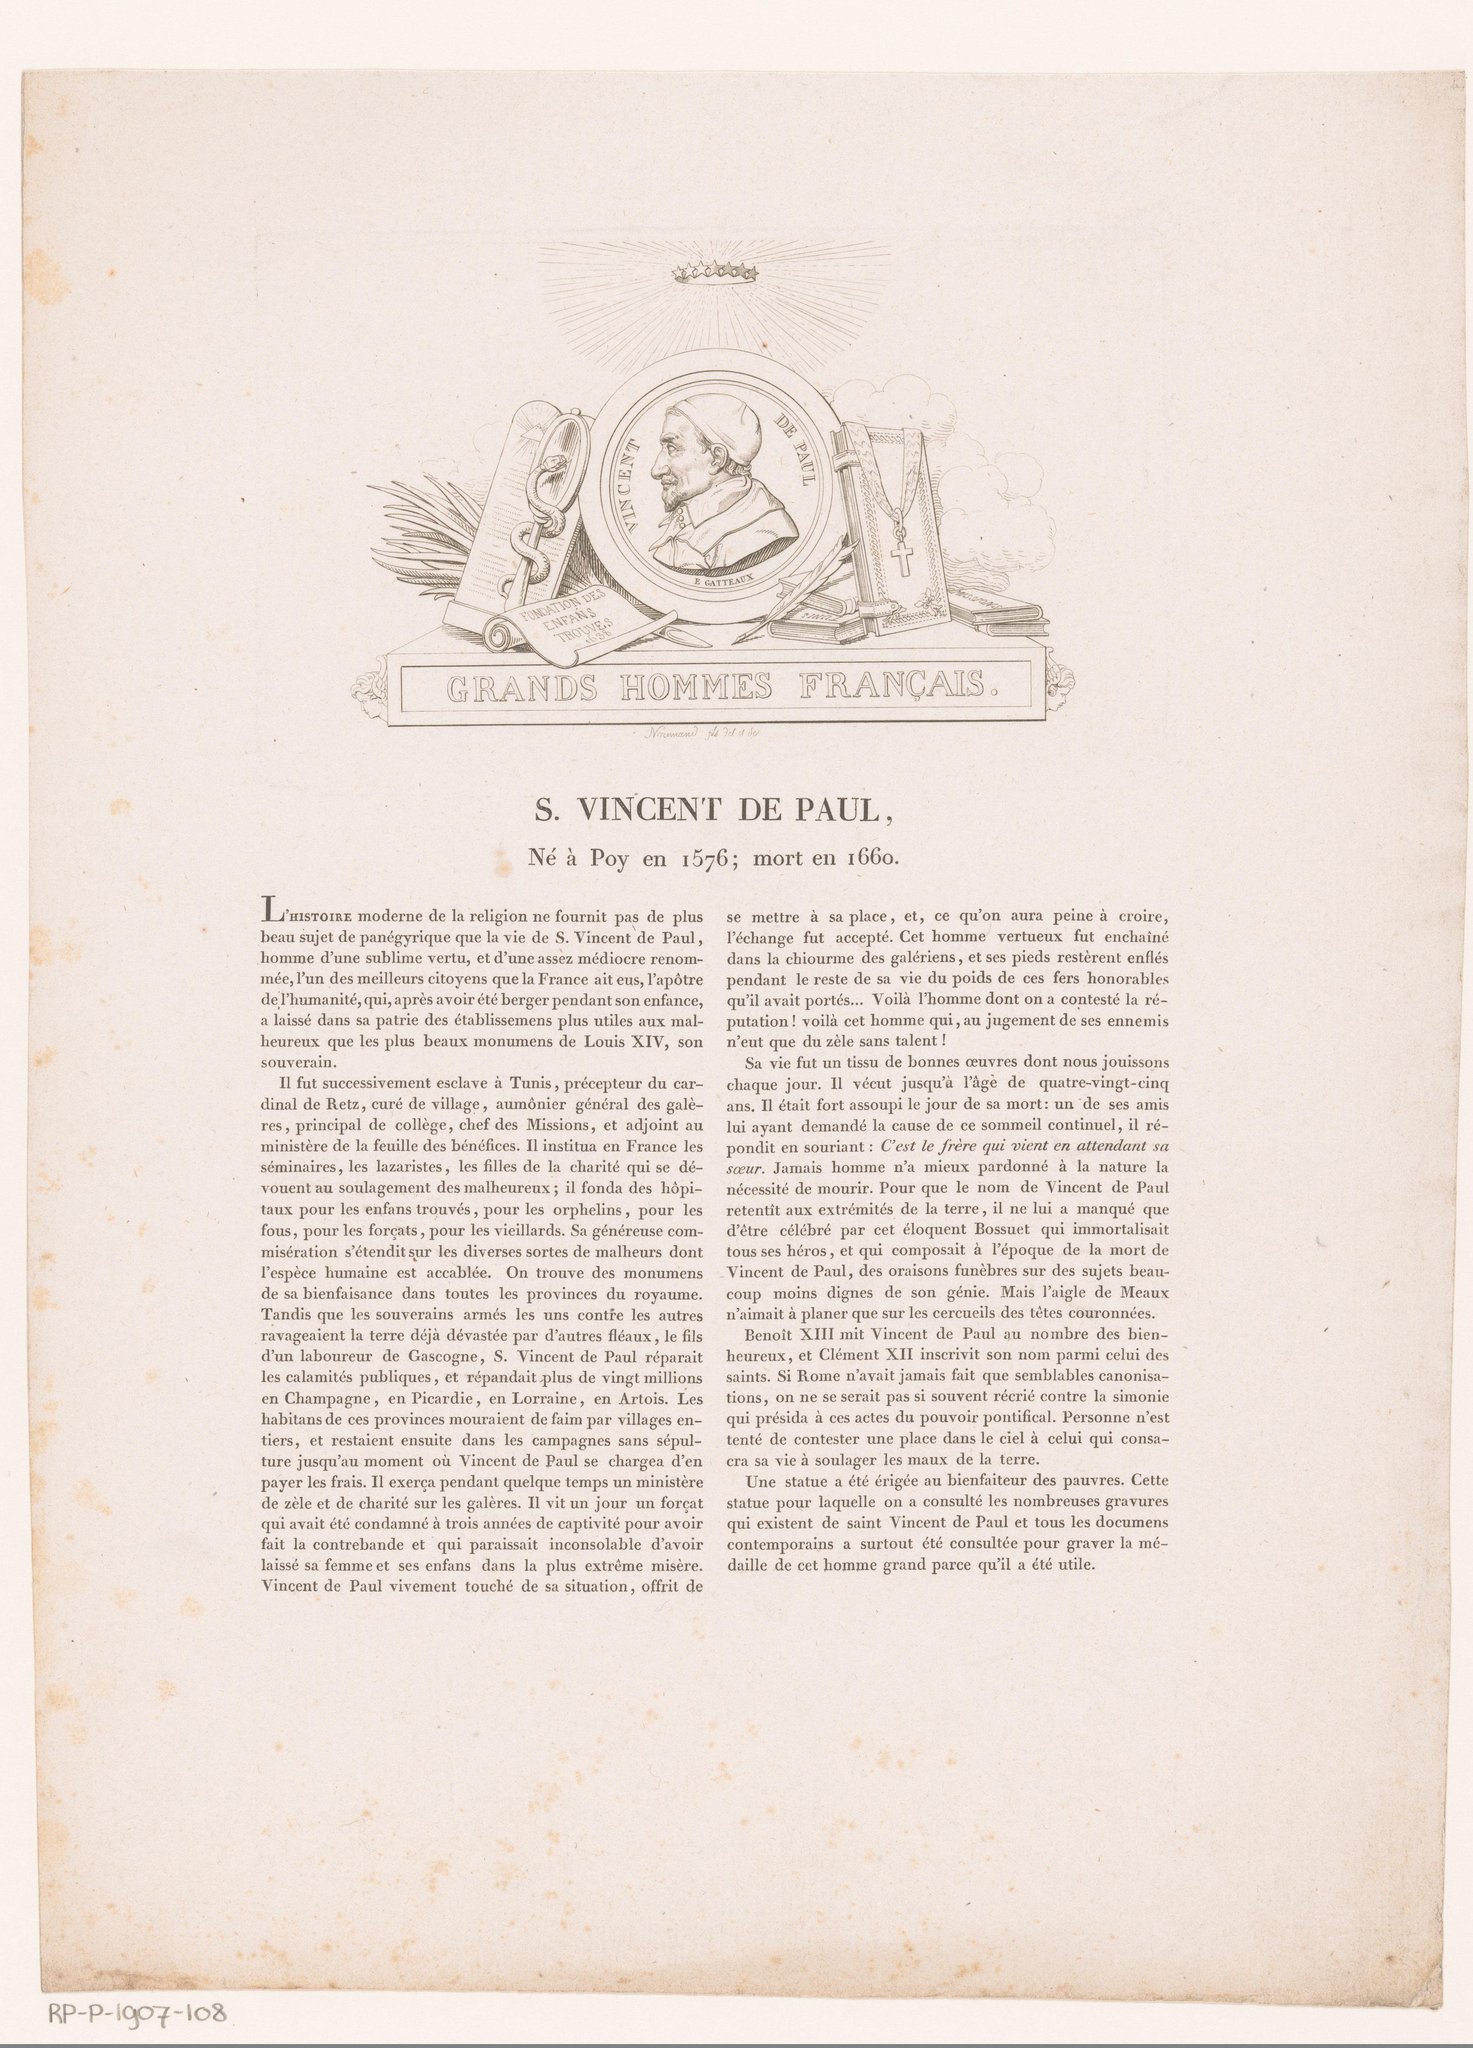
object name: print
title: Portret van Vincentius a Paulo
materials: paper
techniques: etching, letterpress printing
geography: paris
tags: paris, clergyman, priest (roman catholic), historical persons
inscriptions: collector's mark: Lugt 2228